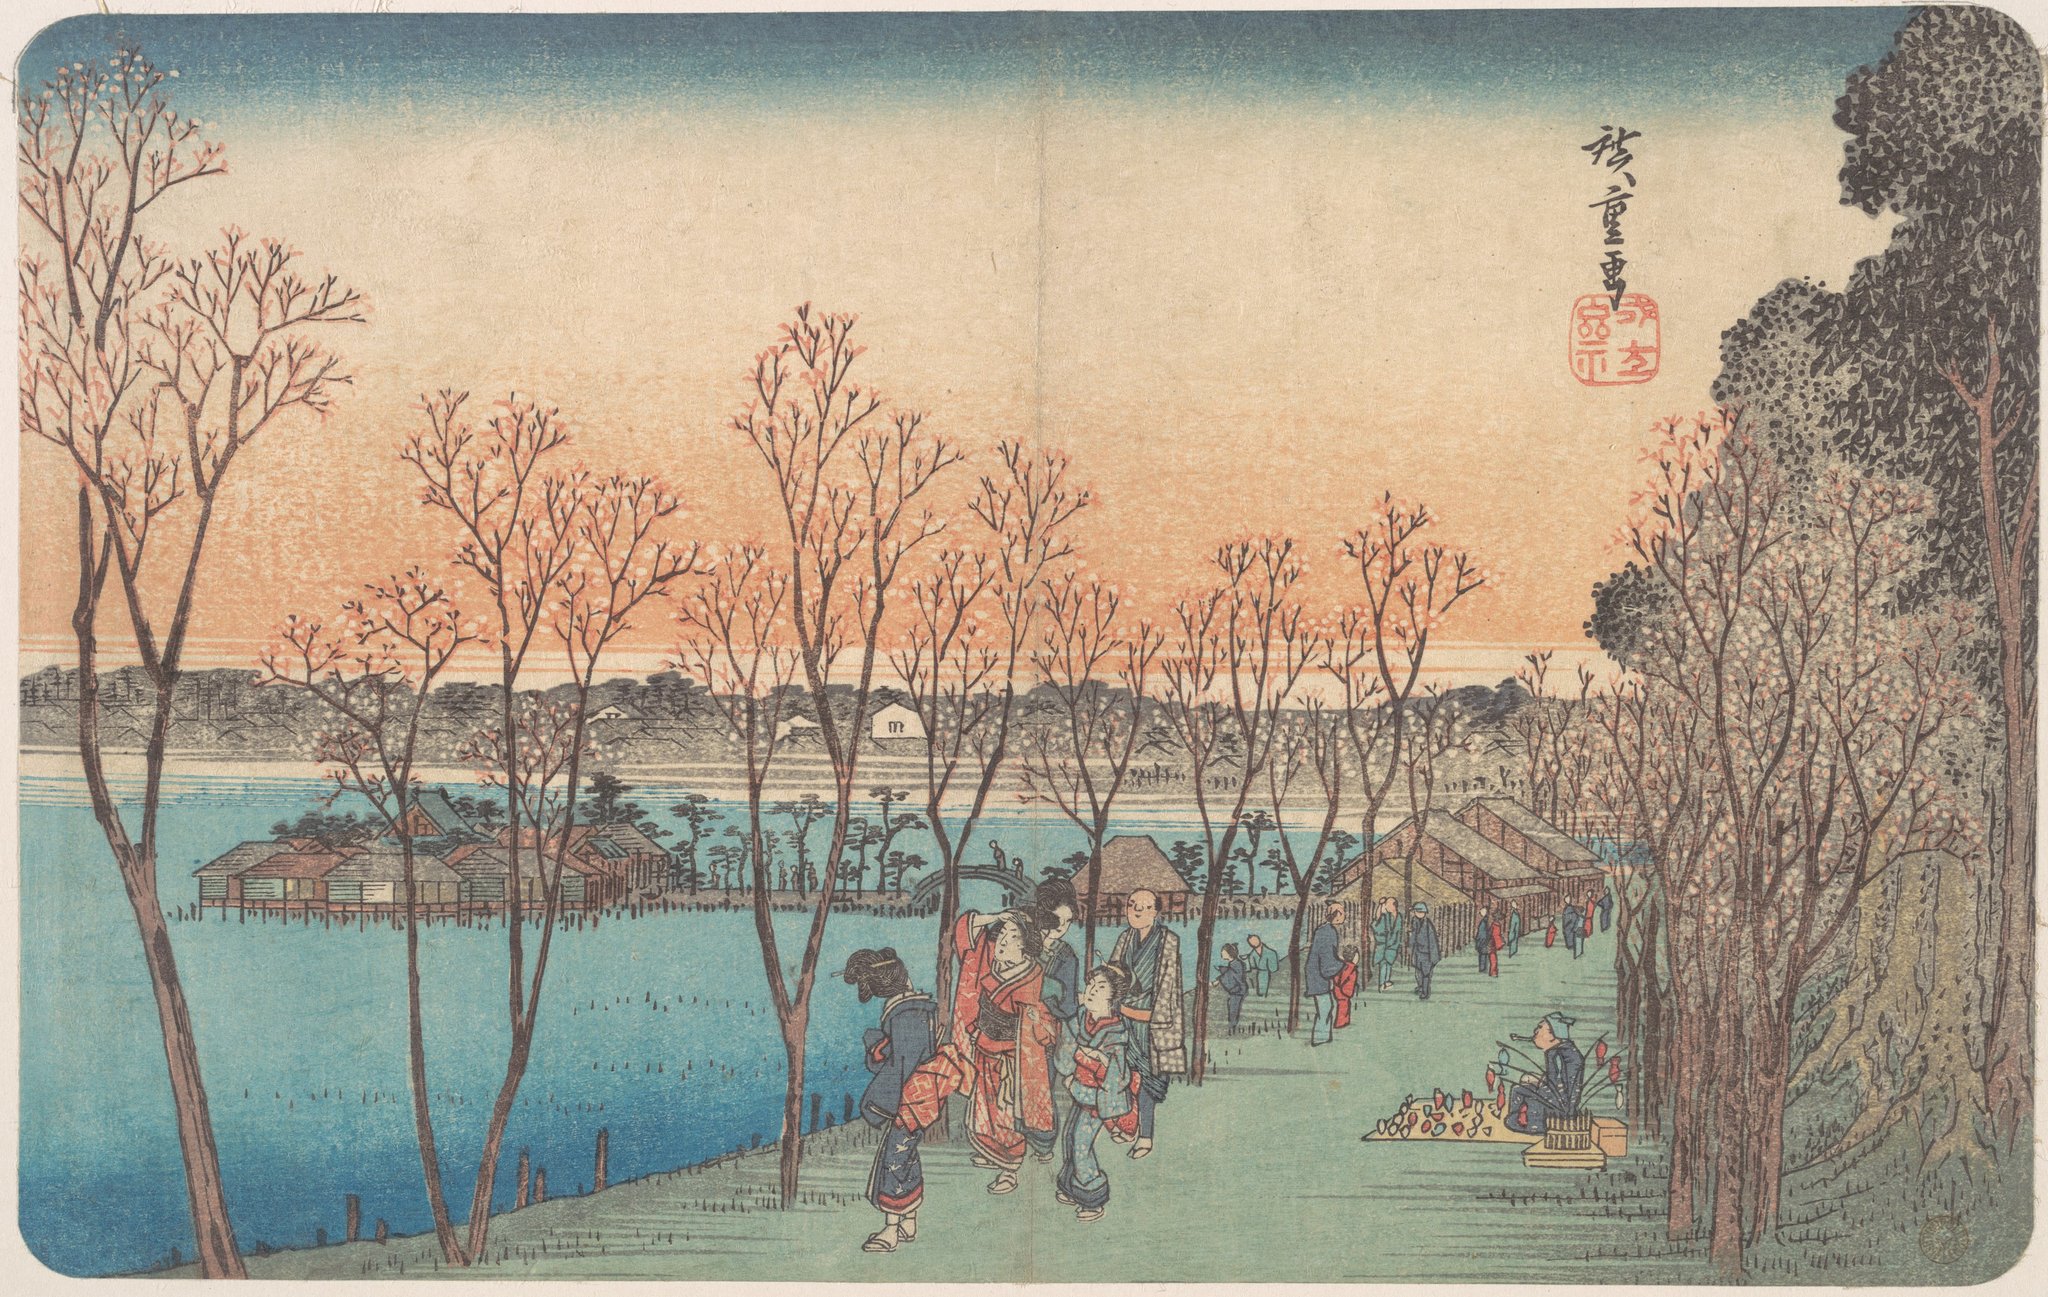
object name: print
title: Ueno, Shinobazu no Ike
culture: japanese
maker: utagawa hiroshige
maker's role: artist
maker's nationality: japanese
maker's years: 1797-1858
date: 1835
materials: ink, paper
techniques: woodblock print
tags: men,women,trees